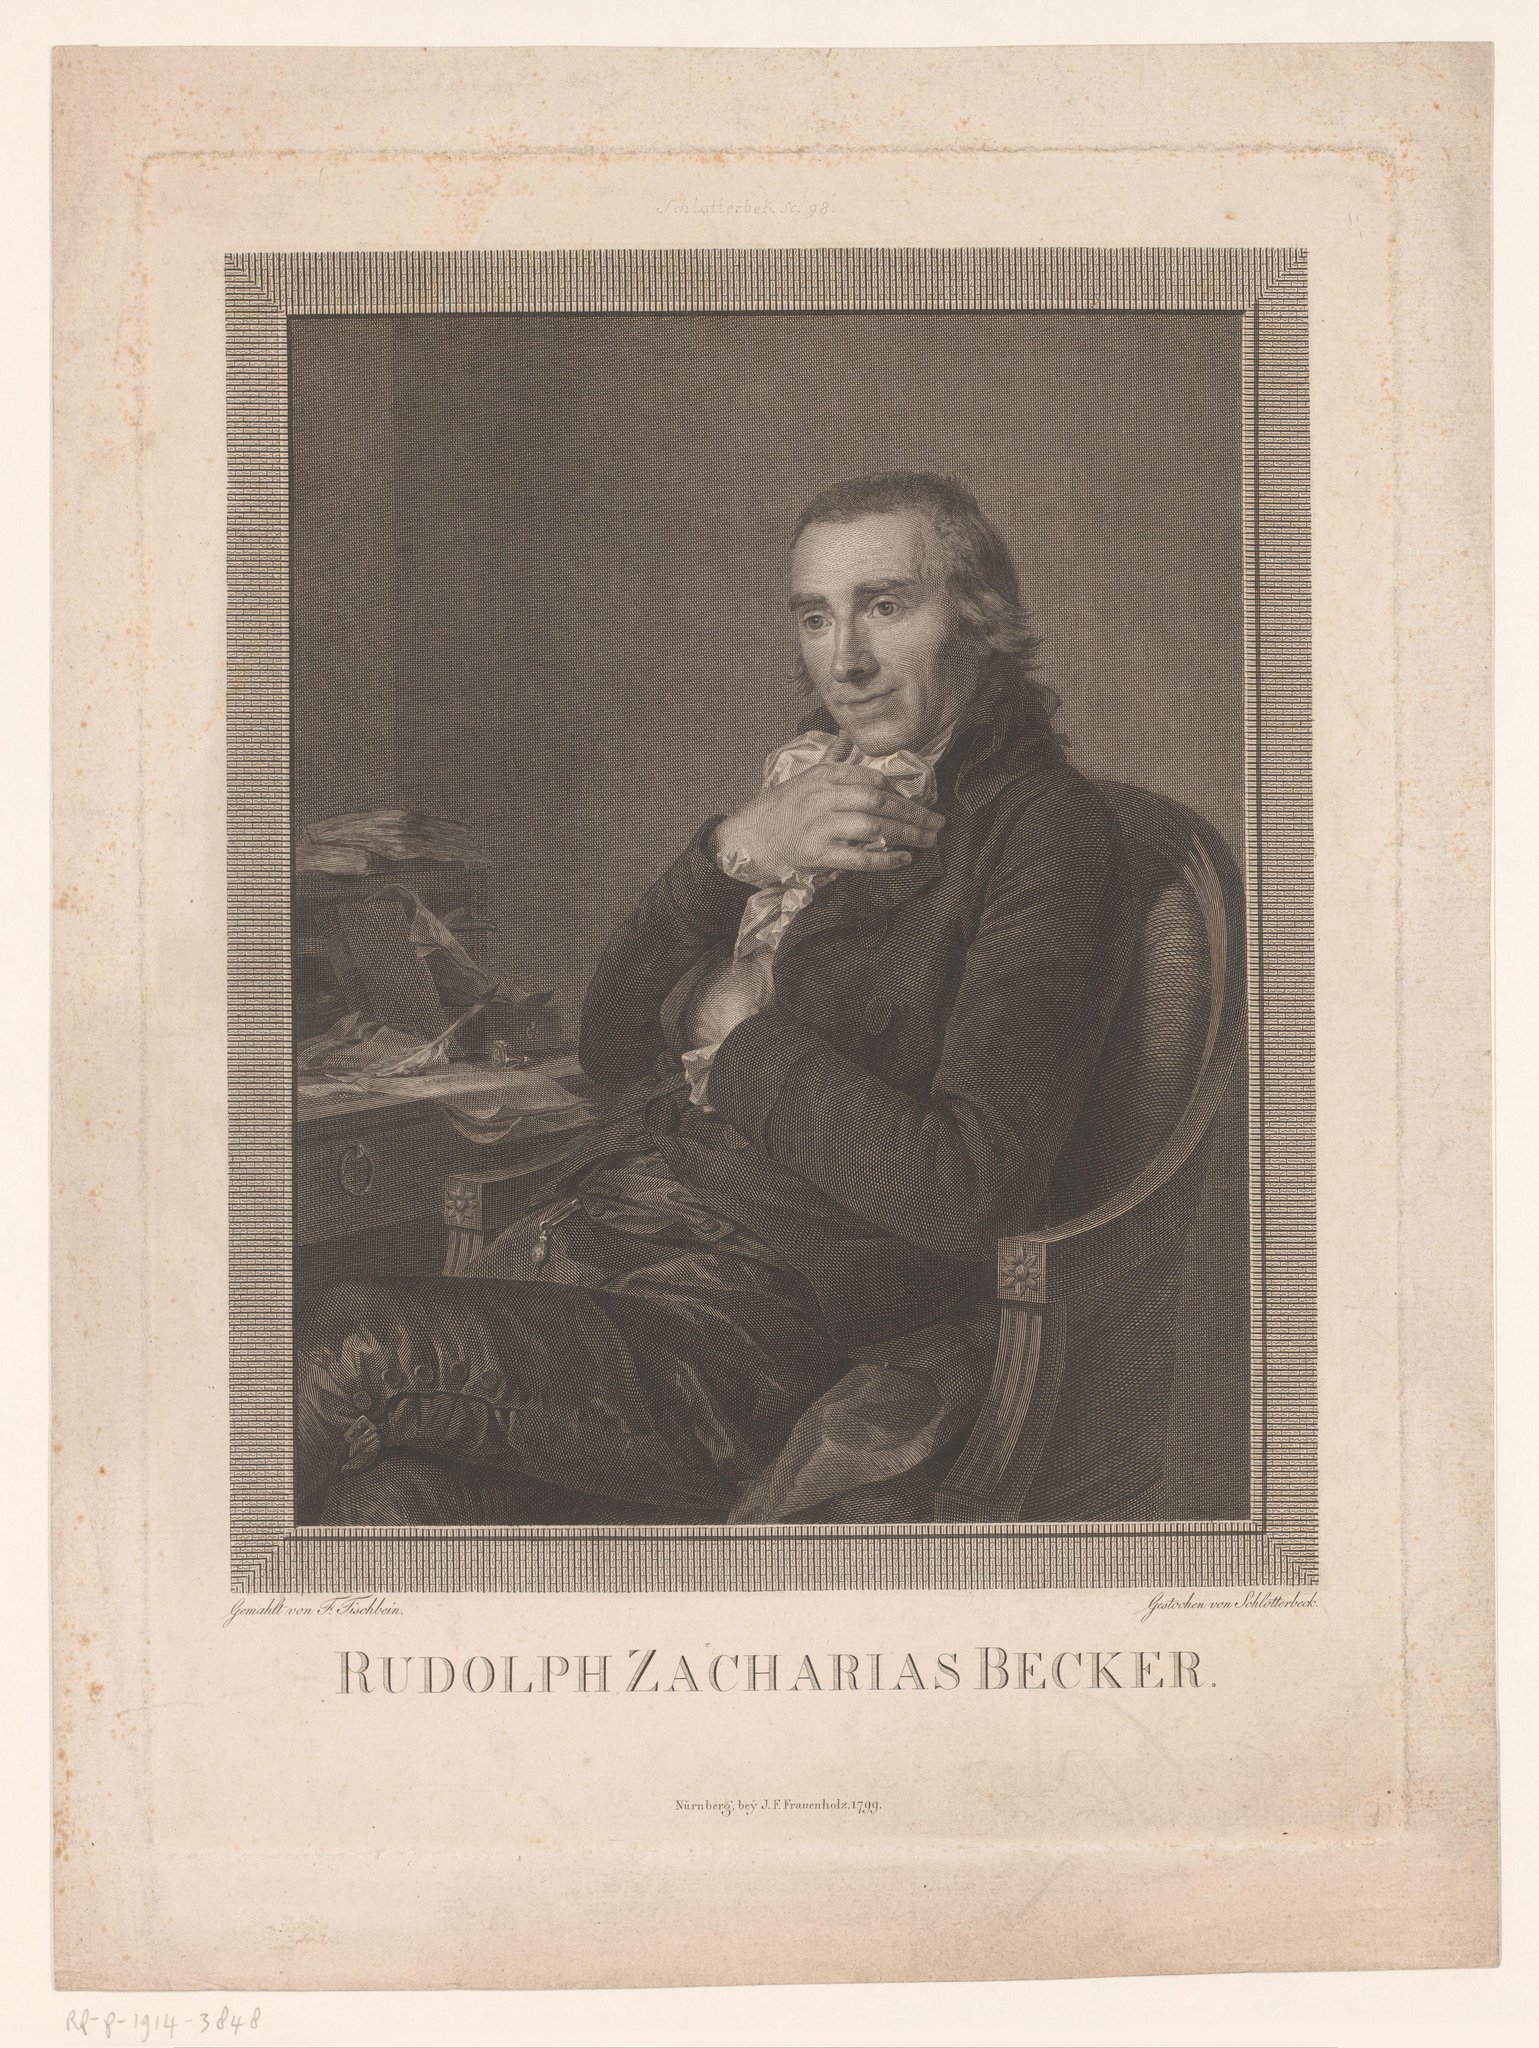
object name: print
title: Portret van Johann Jakob Moser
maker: christian jakob schlotterbeck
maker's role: print maker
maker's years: 1757-1812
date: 1767-1811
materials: paper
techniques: engraving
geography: stuttgart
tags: politician, historical persons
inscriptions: collector's mark: Lugt 2228